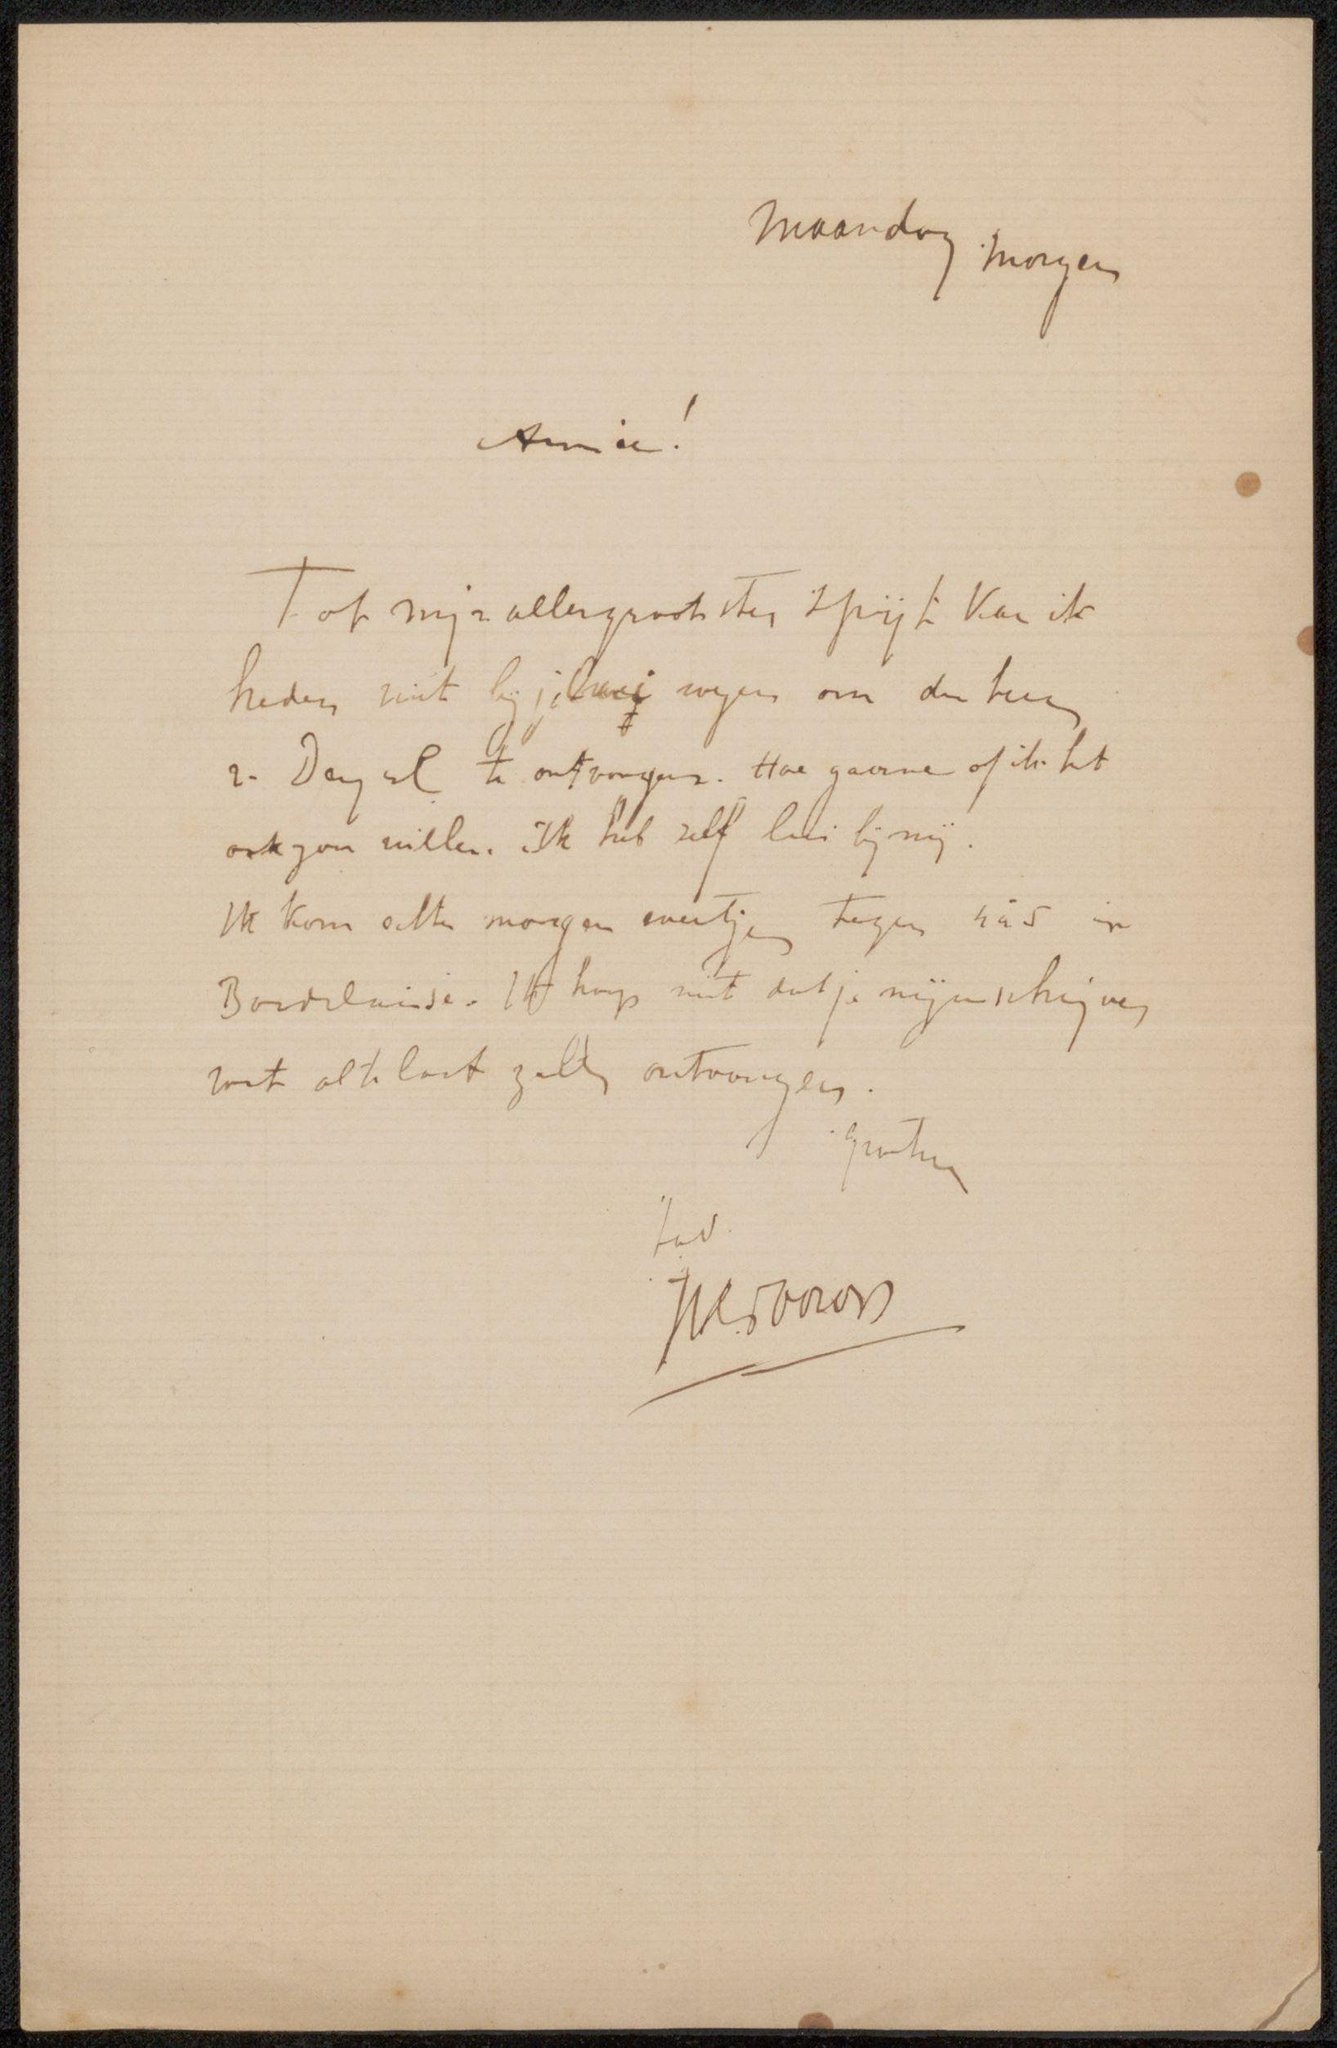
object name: letter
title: Brief aan Philip Zilcken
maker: jan toorop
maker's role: draughtsman, painter, print maker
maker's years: 1858-1928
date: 1868-1928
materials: ink, paper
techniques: pen, writing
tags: lodewijk van deyssel, philip zilcken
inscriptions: collector's mark: ‘RPK’